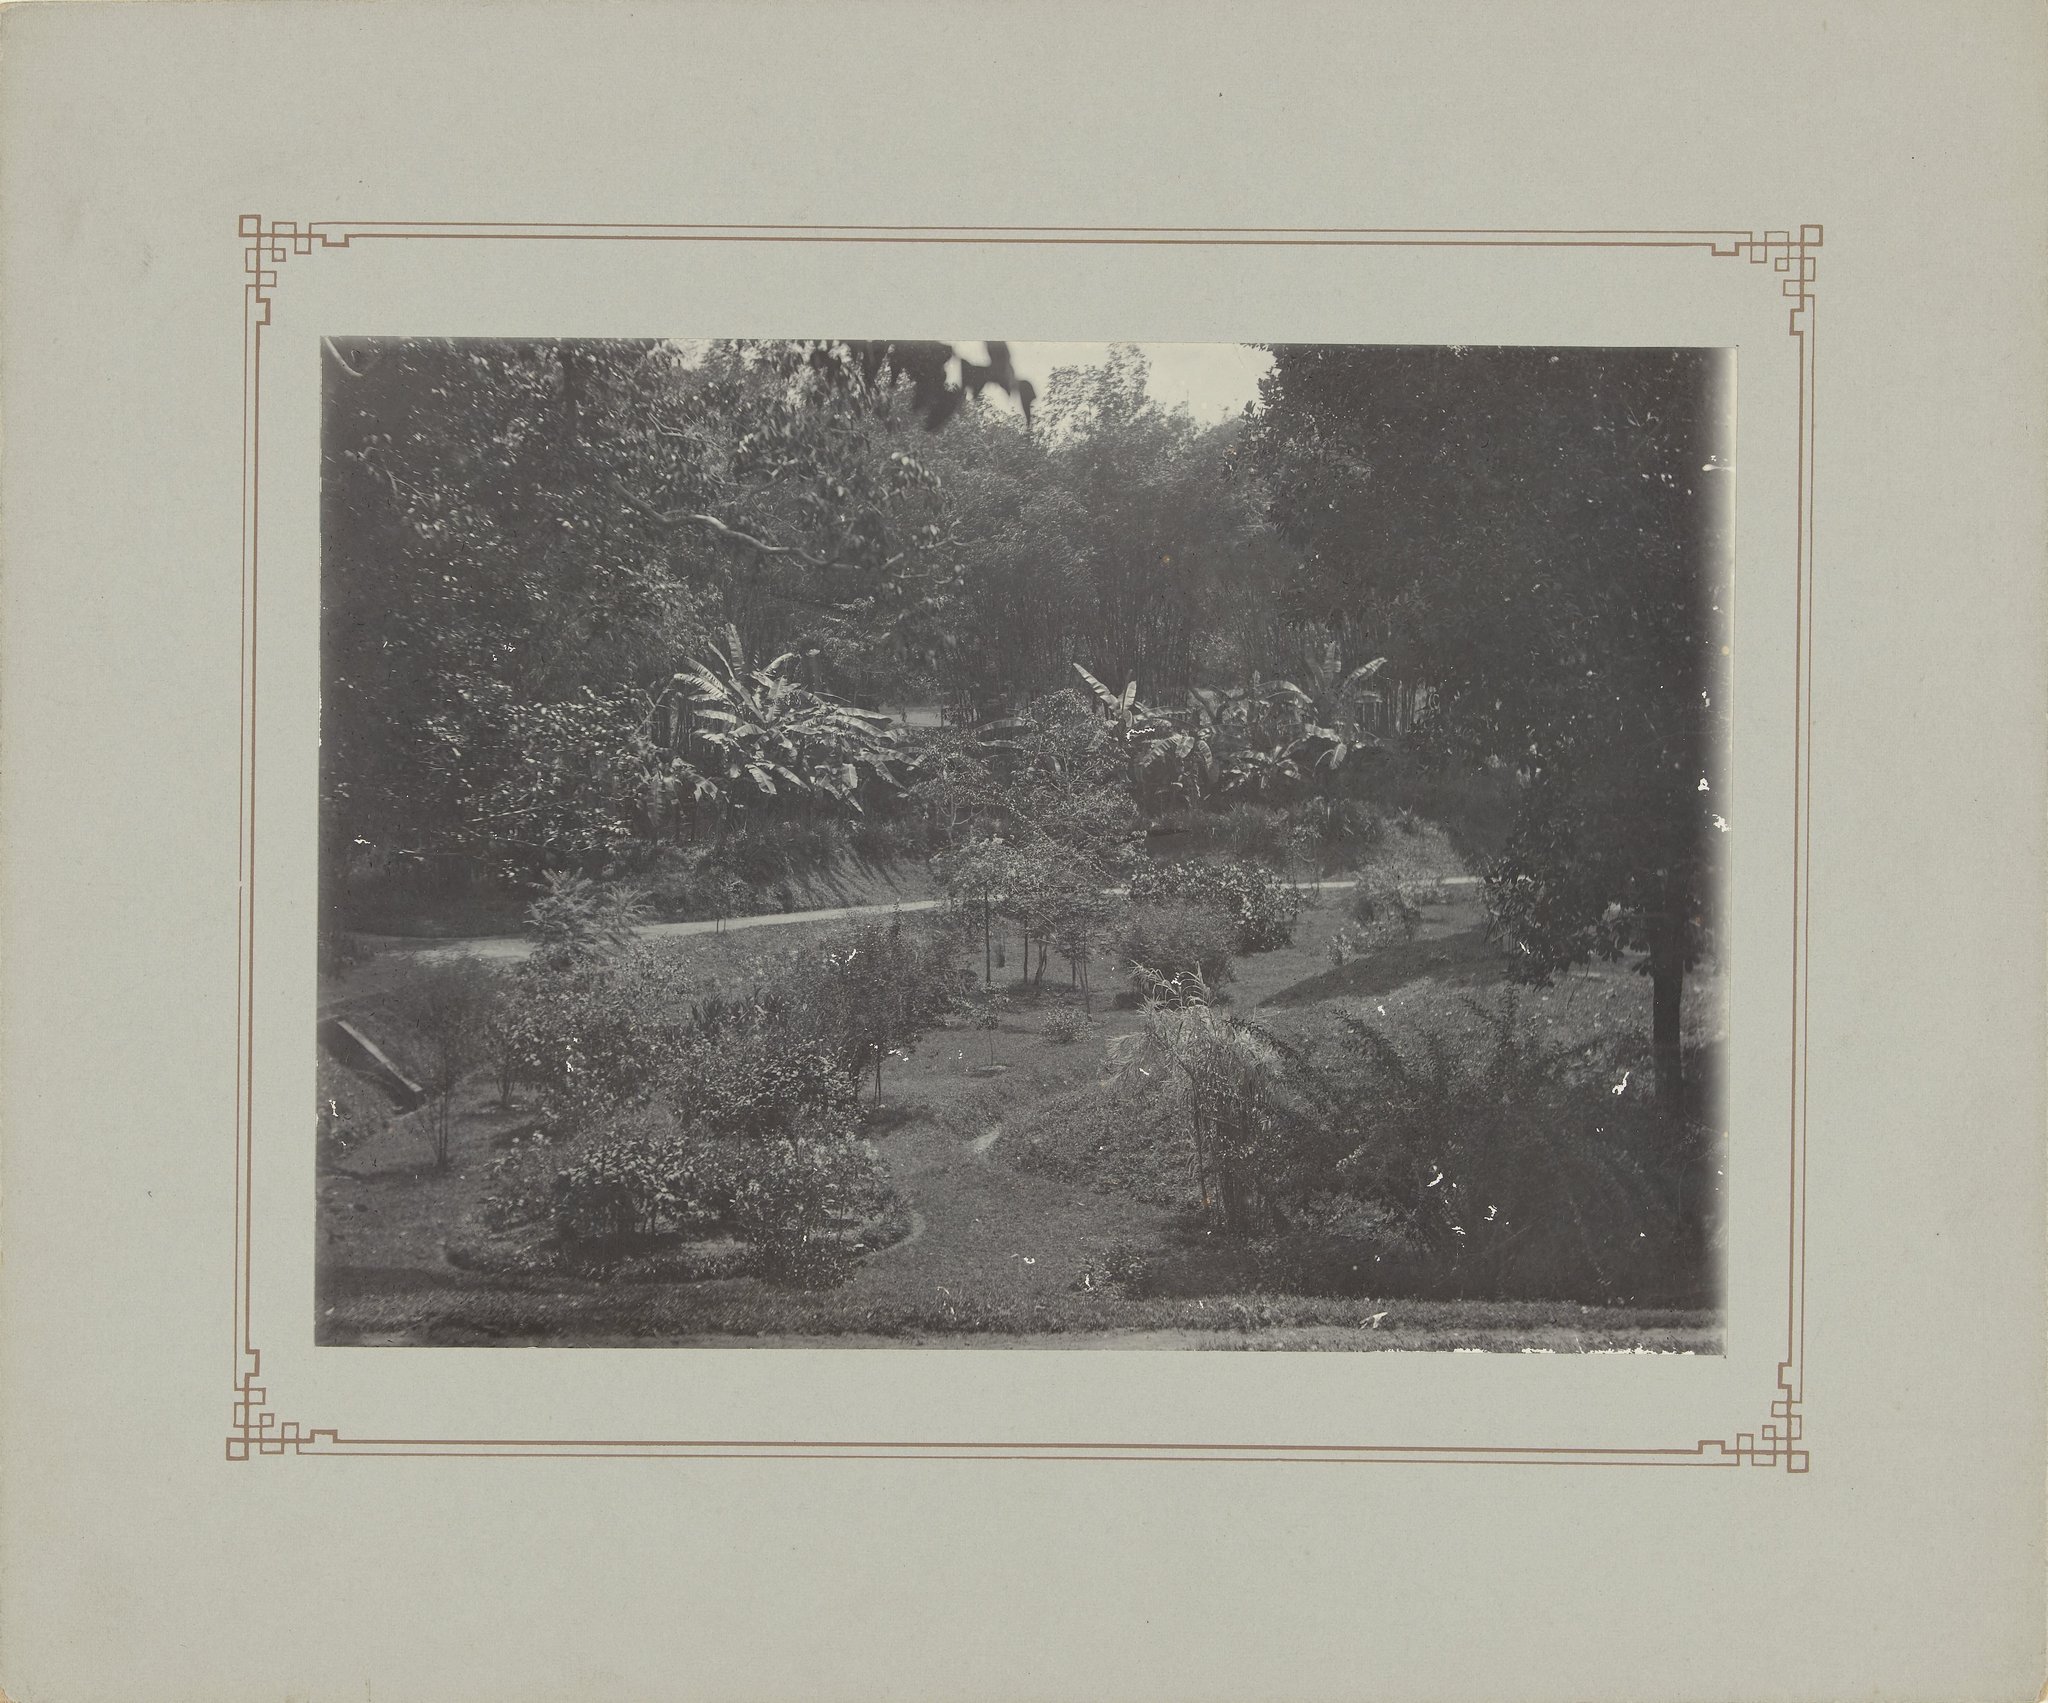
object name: photograph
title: Tuin of park in Nederlands-Indië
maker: Anonymous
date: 1890-1920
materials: paper, cardboard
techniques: gelatin silver print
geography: dutch east indies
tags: park, garden, dutch east indies, the